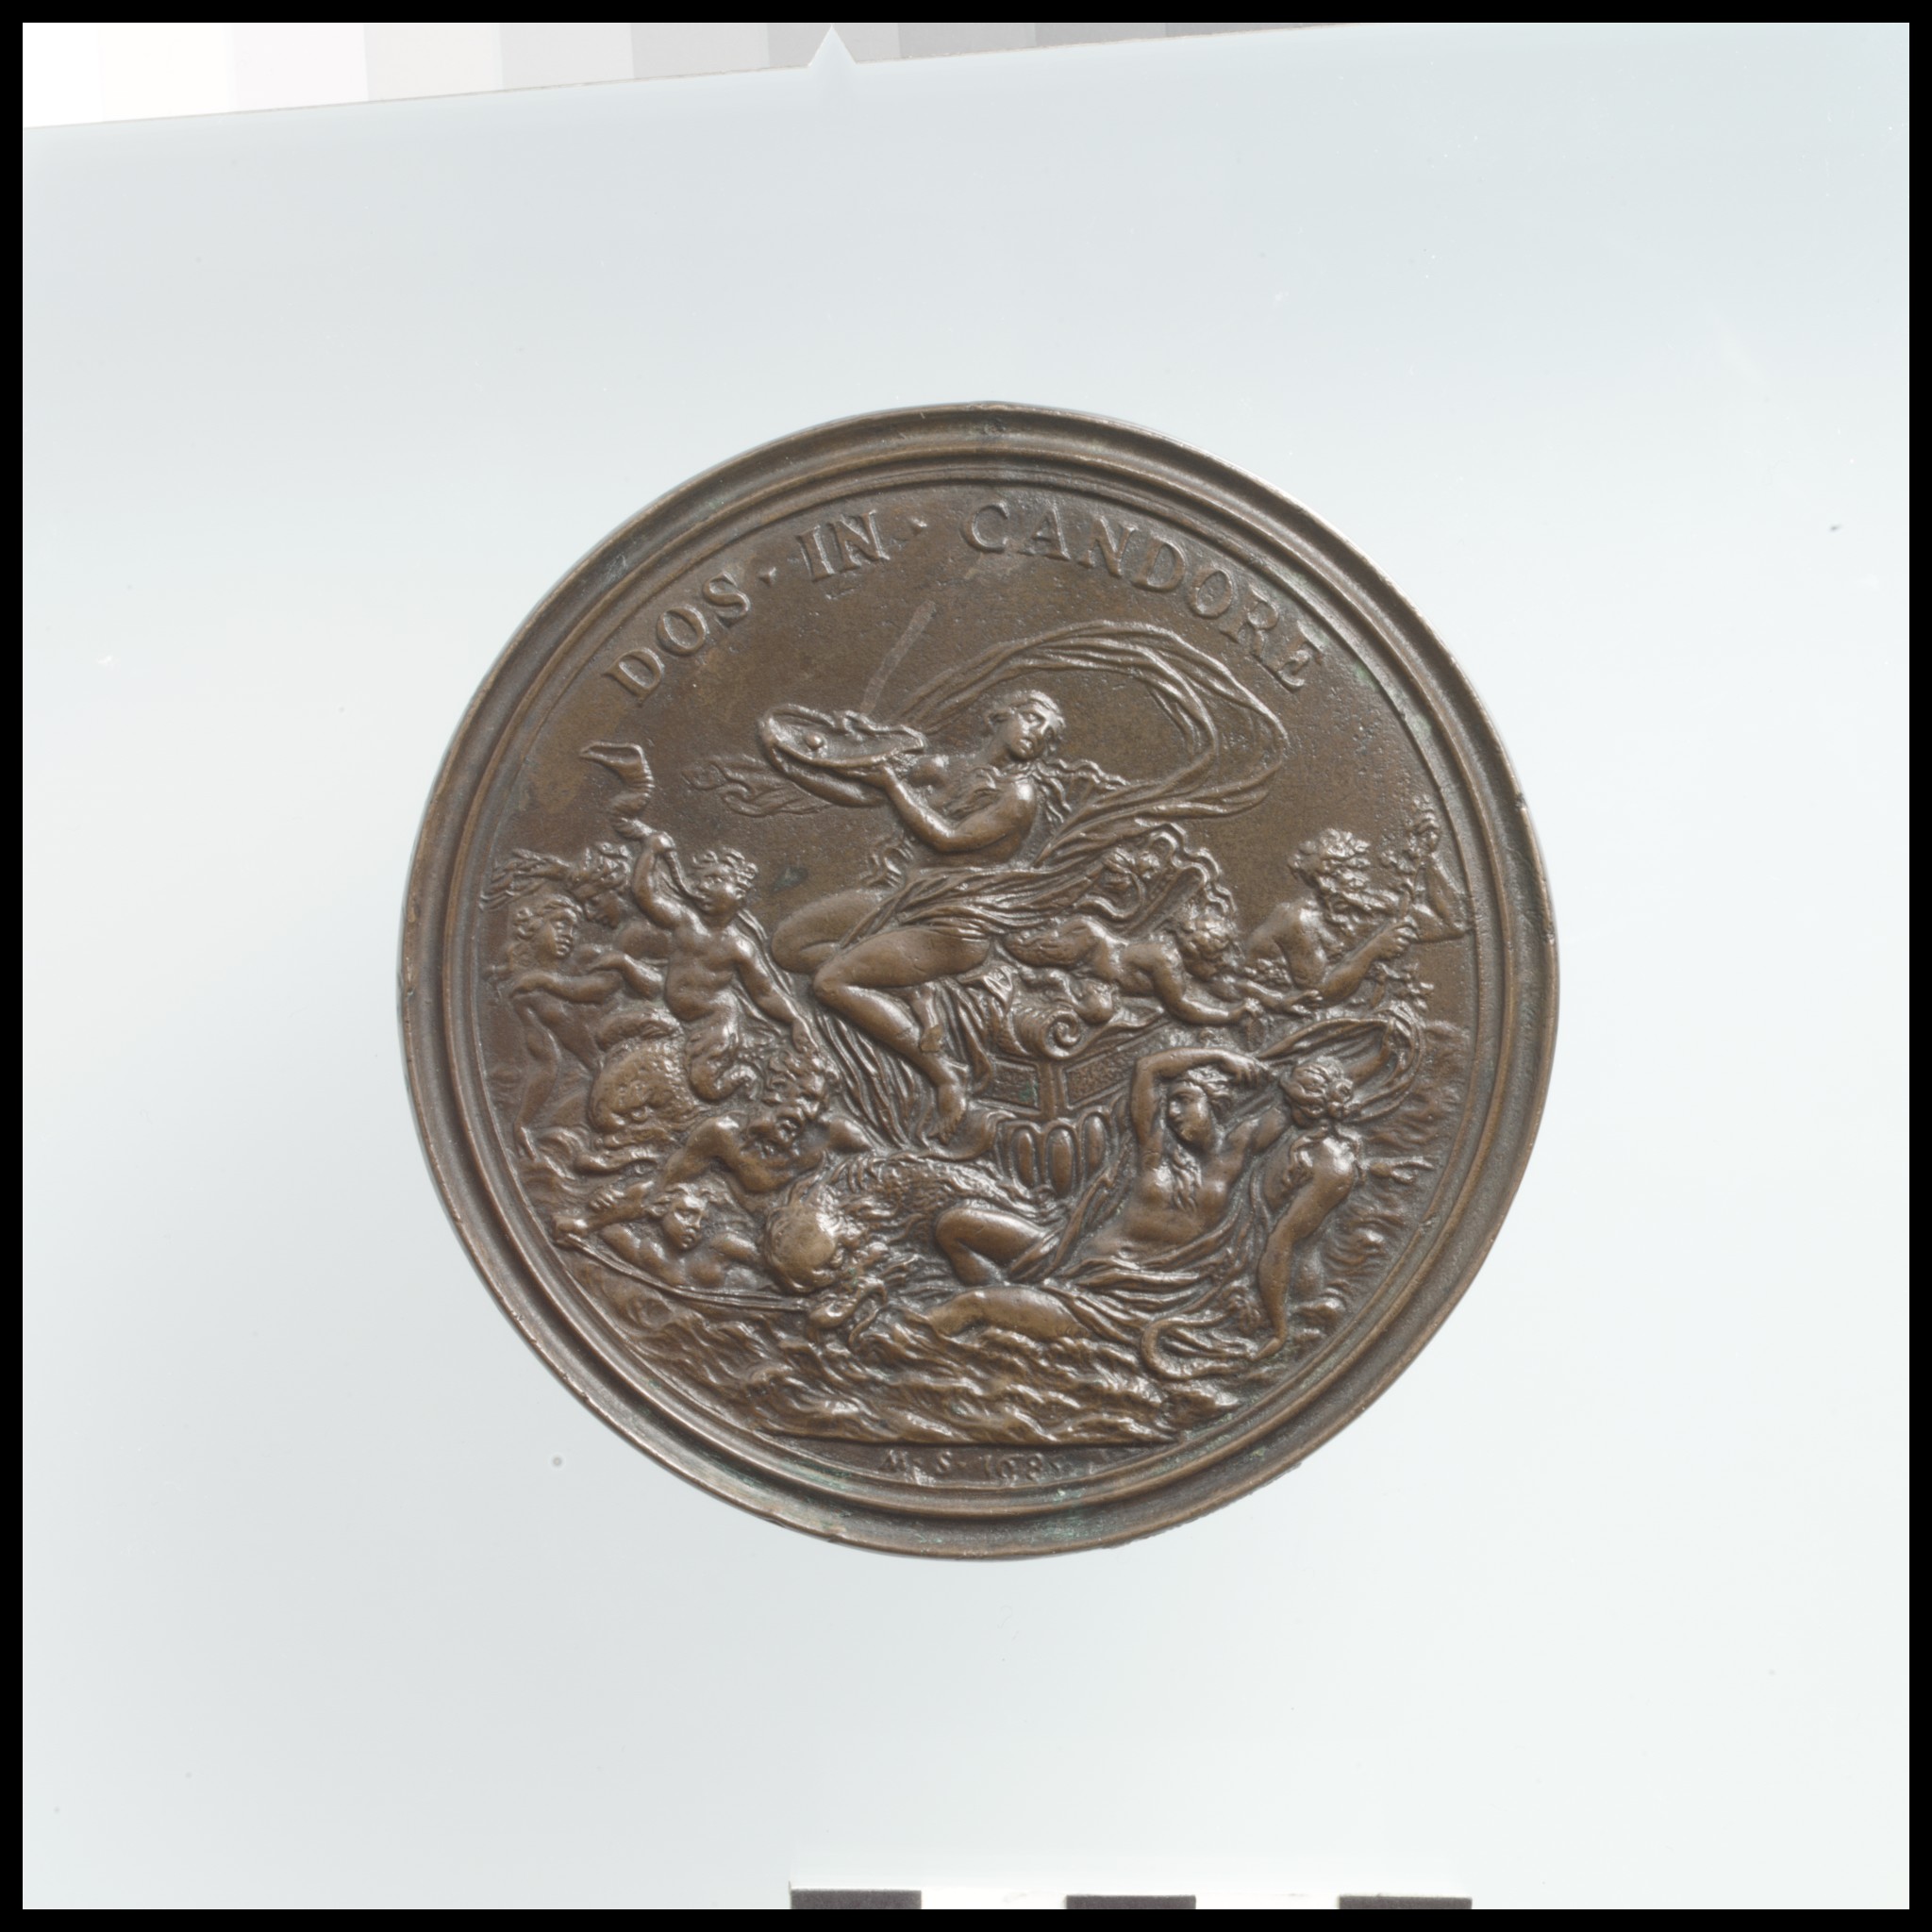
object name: medal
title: Vittoria della Rovere, Grand Duchess of Tuscany (1622-94)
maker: massimiliano soldani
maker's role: artist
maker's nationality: italian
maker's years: 1656-1740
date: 1685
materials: bronze, patina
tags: profiles,female nudes